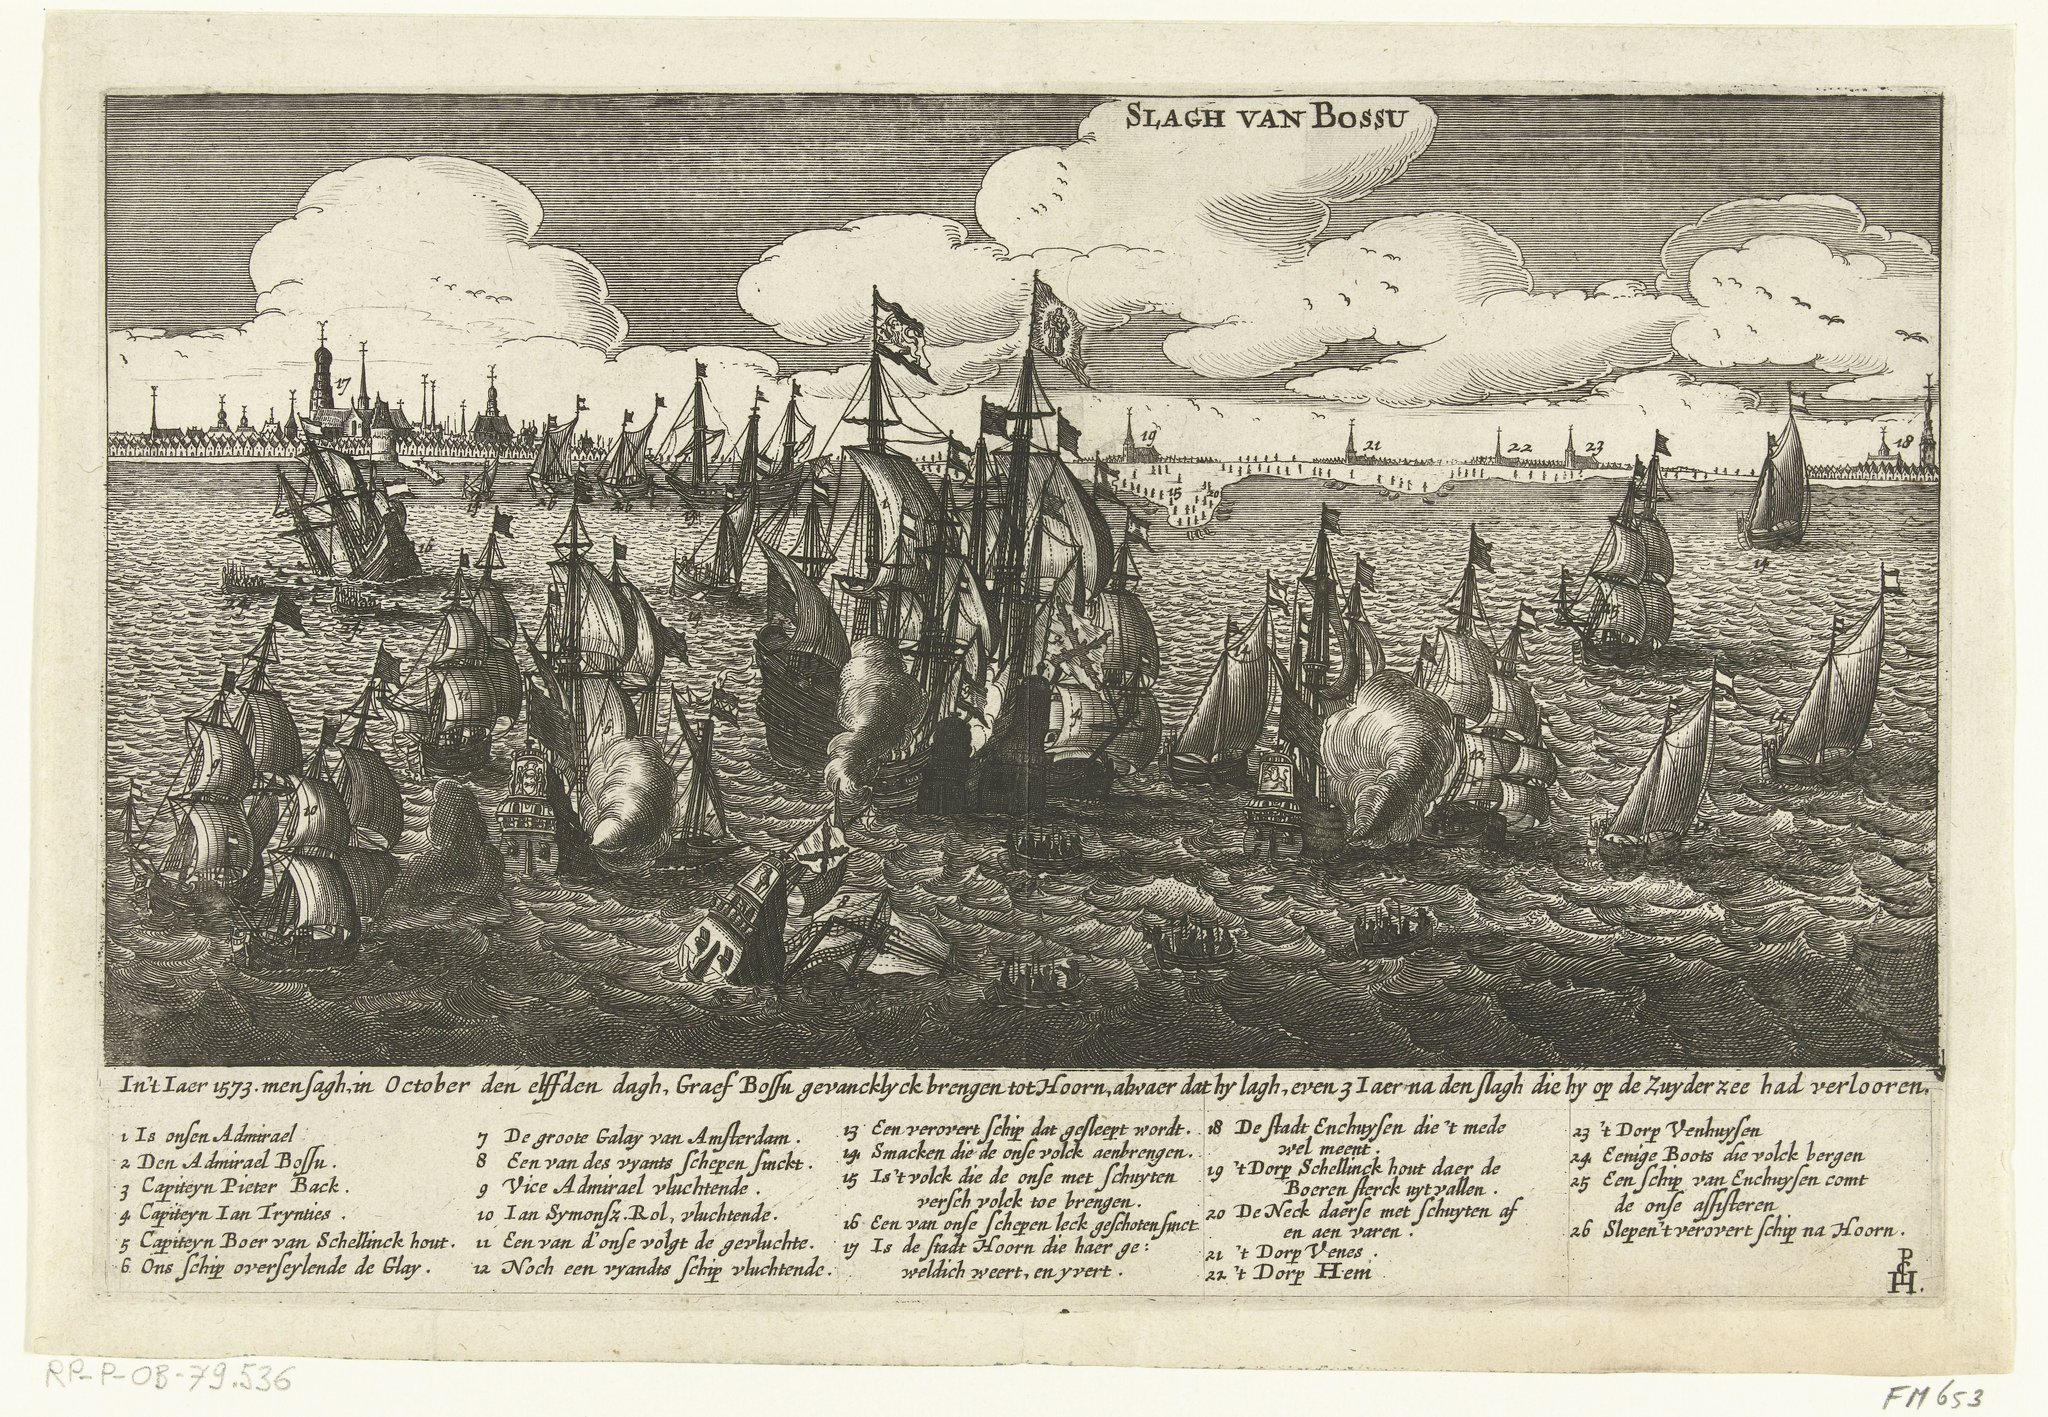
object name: history print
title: Slag op de Zuiderzee tegen de graaf van Bossu, 1573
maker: hendrik cornelisz. pot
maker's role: print maker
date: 1647-1676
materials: paper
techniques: engraving, etching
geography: northern netherlands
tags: antwerp, earl, politician, battle (+ naval force), zuiderzee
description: De slag op de Zuiderzee, 11 oktober 1573. Zeeslag waarbij de vloot van de watergeuzen onder leiding van Cornelis Dirkszoon van Monnickendam de Spaanse vloot van Bossu verslaat. Op de voorgrond sloepen en een zinkend schip, daarachter de grotere schepen. Op de achtergrond de kustlijn van Hoorn tot Enkhuizen. Met onderschrift van 1 regel en de legenda 1-26 in het Nederlands.